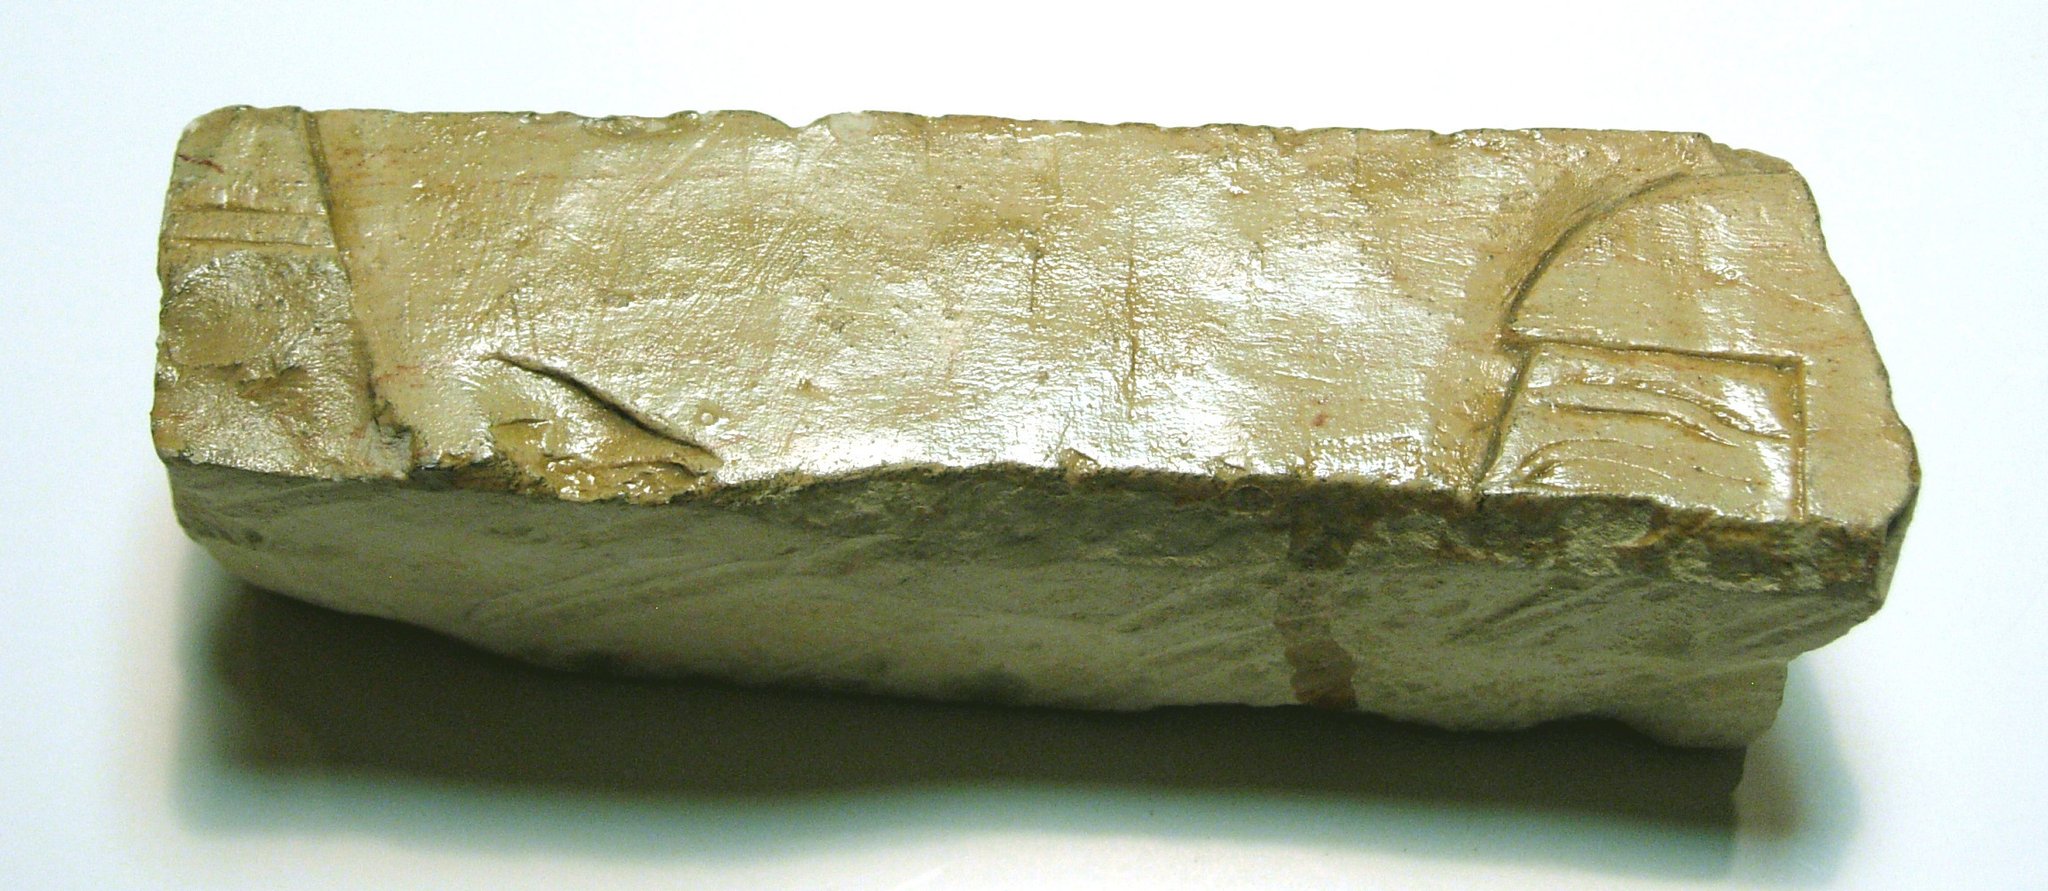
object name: relief, tomb of nespekashuty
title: Raised relief fragment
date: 664-610 BCE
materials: limestone, varnish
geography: egypt